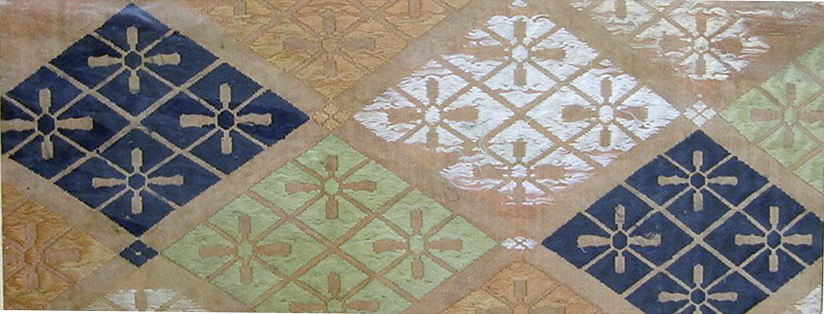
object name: piece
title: Textile with Floral Lozenges (hanabishi)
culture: japanese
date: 1615-1868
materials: silk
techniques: brocade, weave